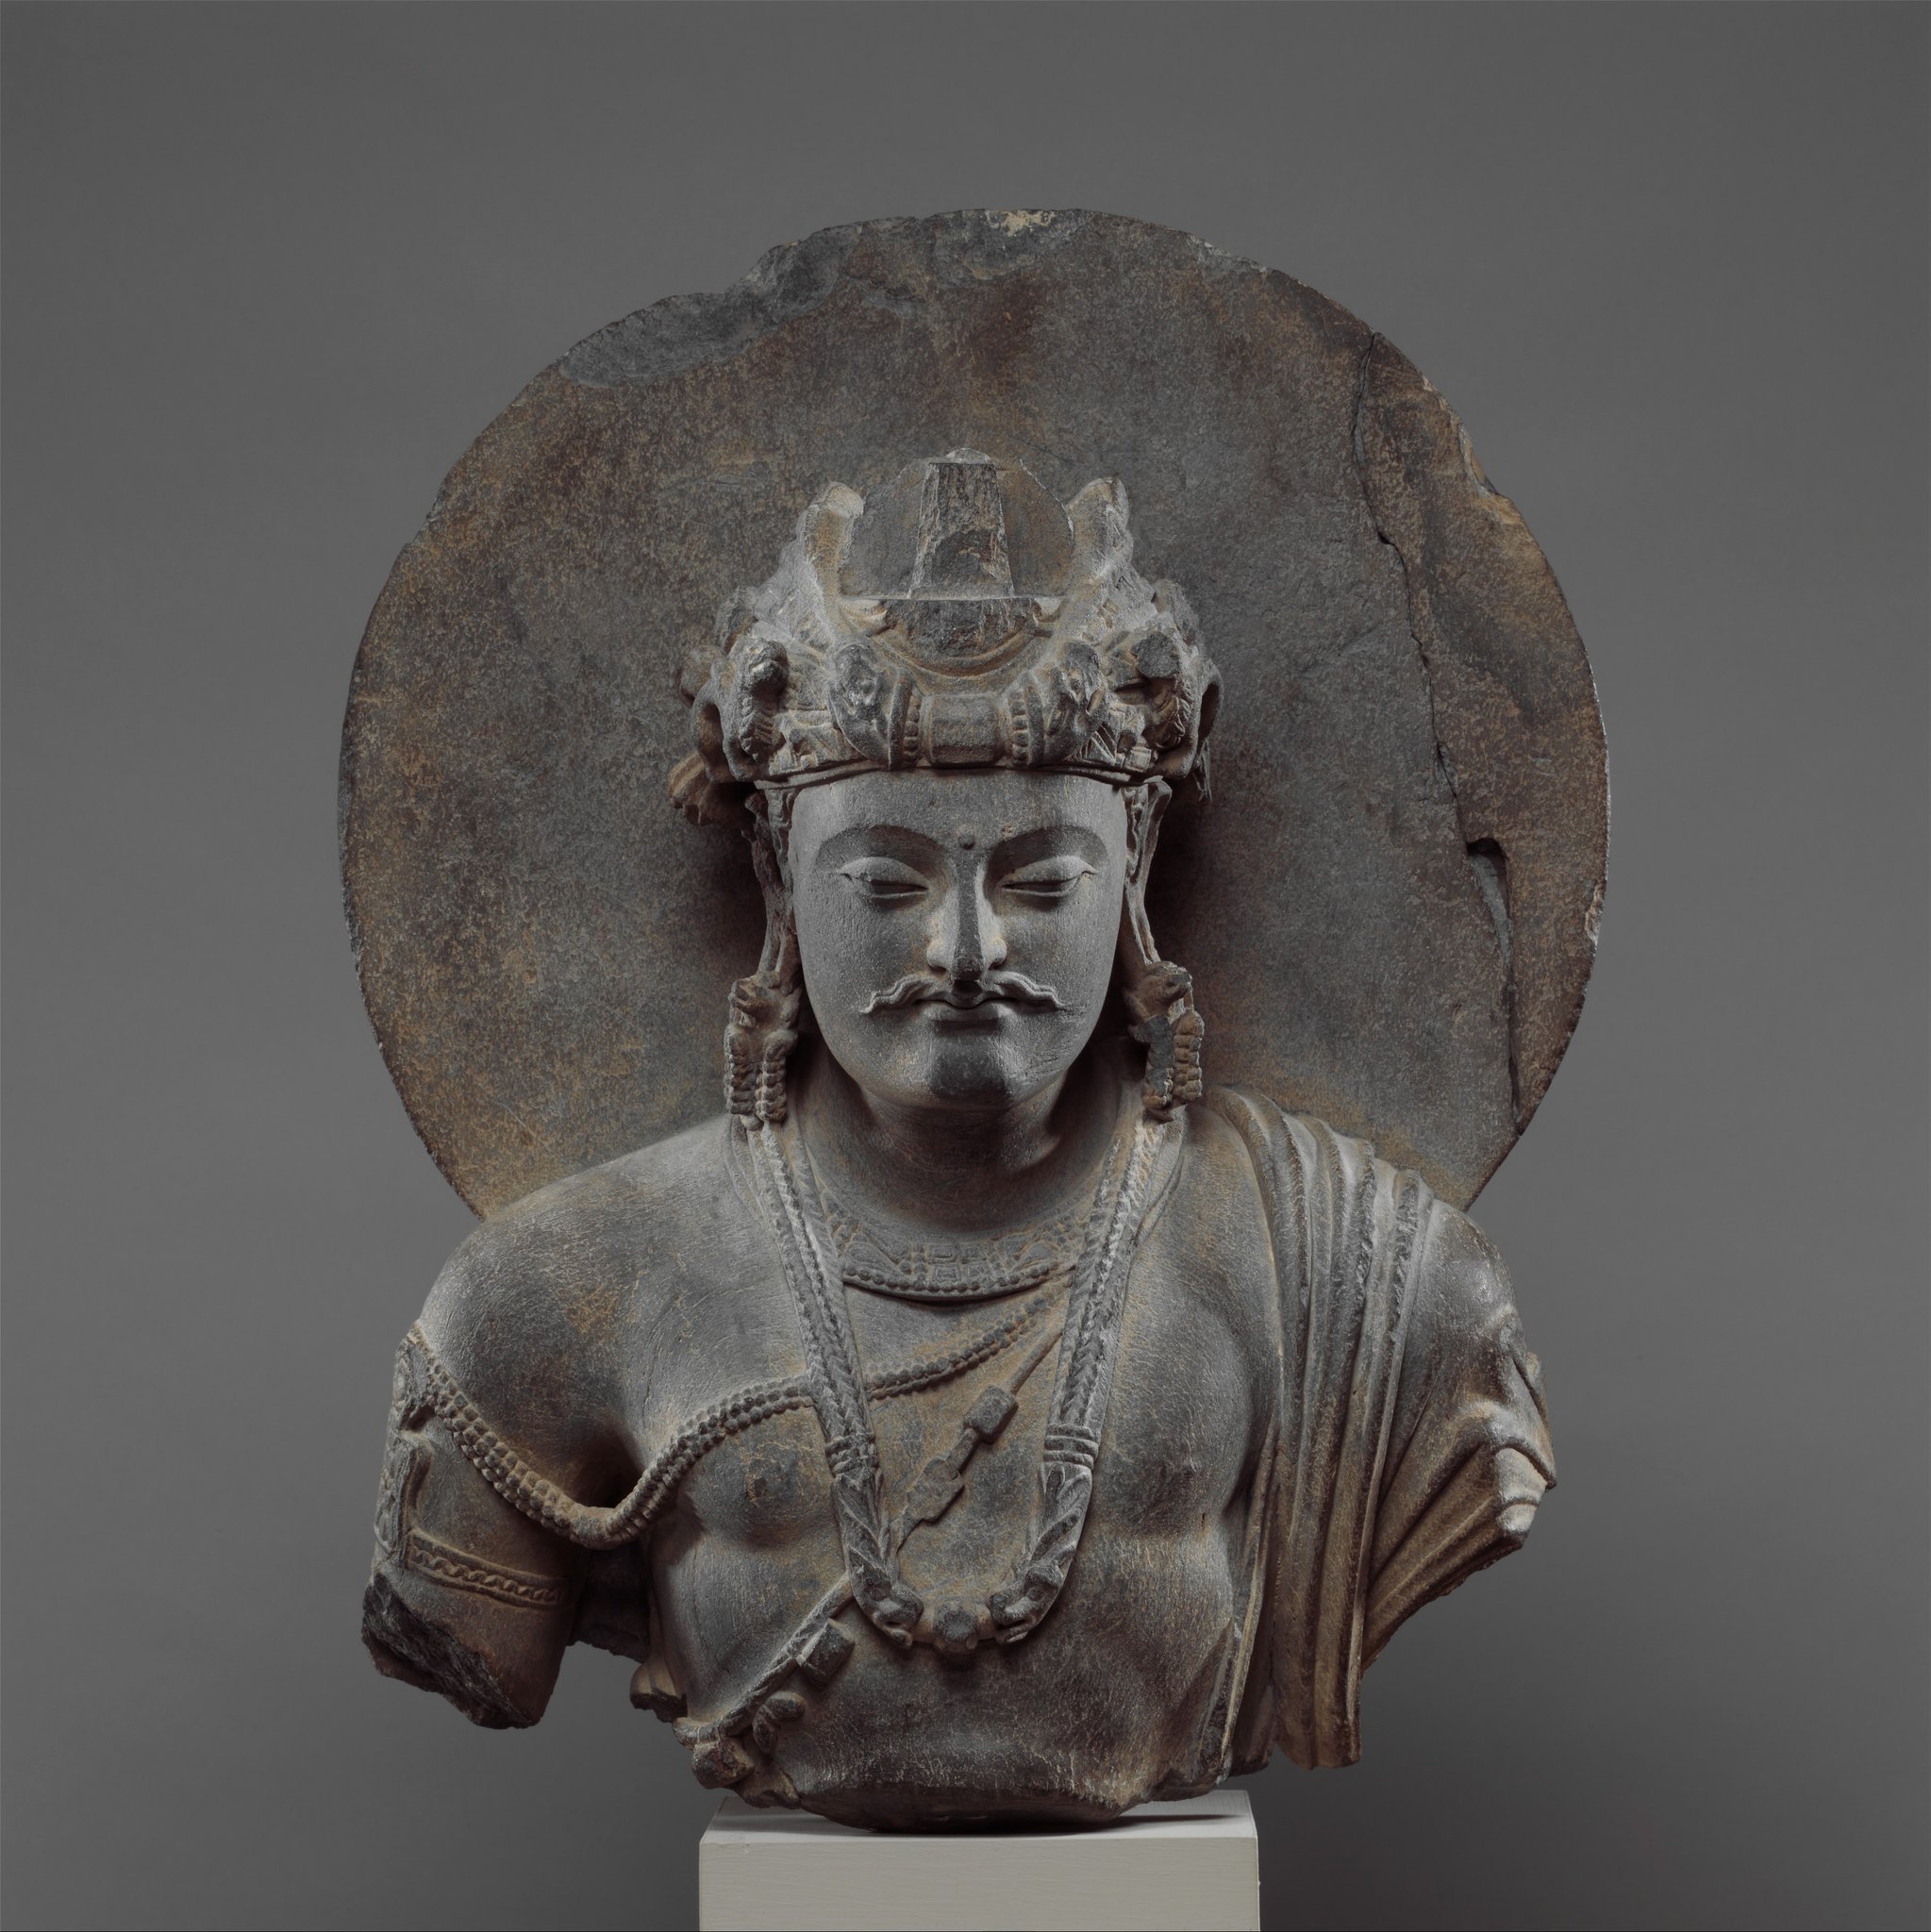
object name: bust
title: Bust of a Bodhisattva Shakyamuni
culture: gandhara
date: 201-400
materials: stone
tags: gandhara,buddhism,bodhisattvas,shakyamuni